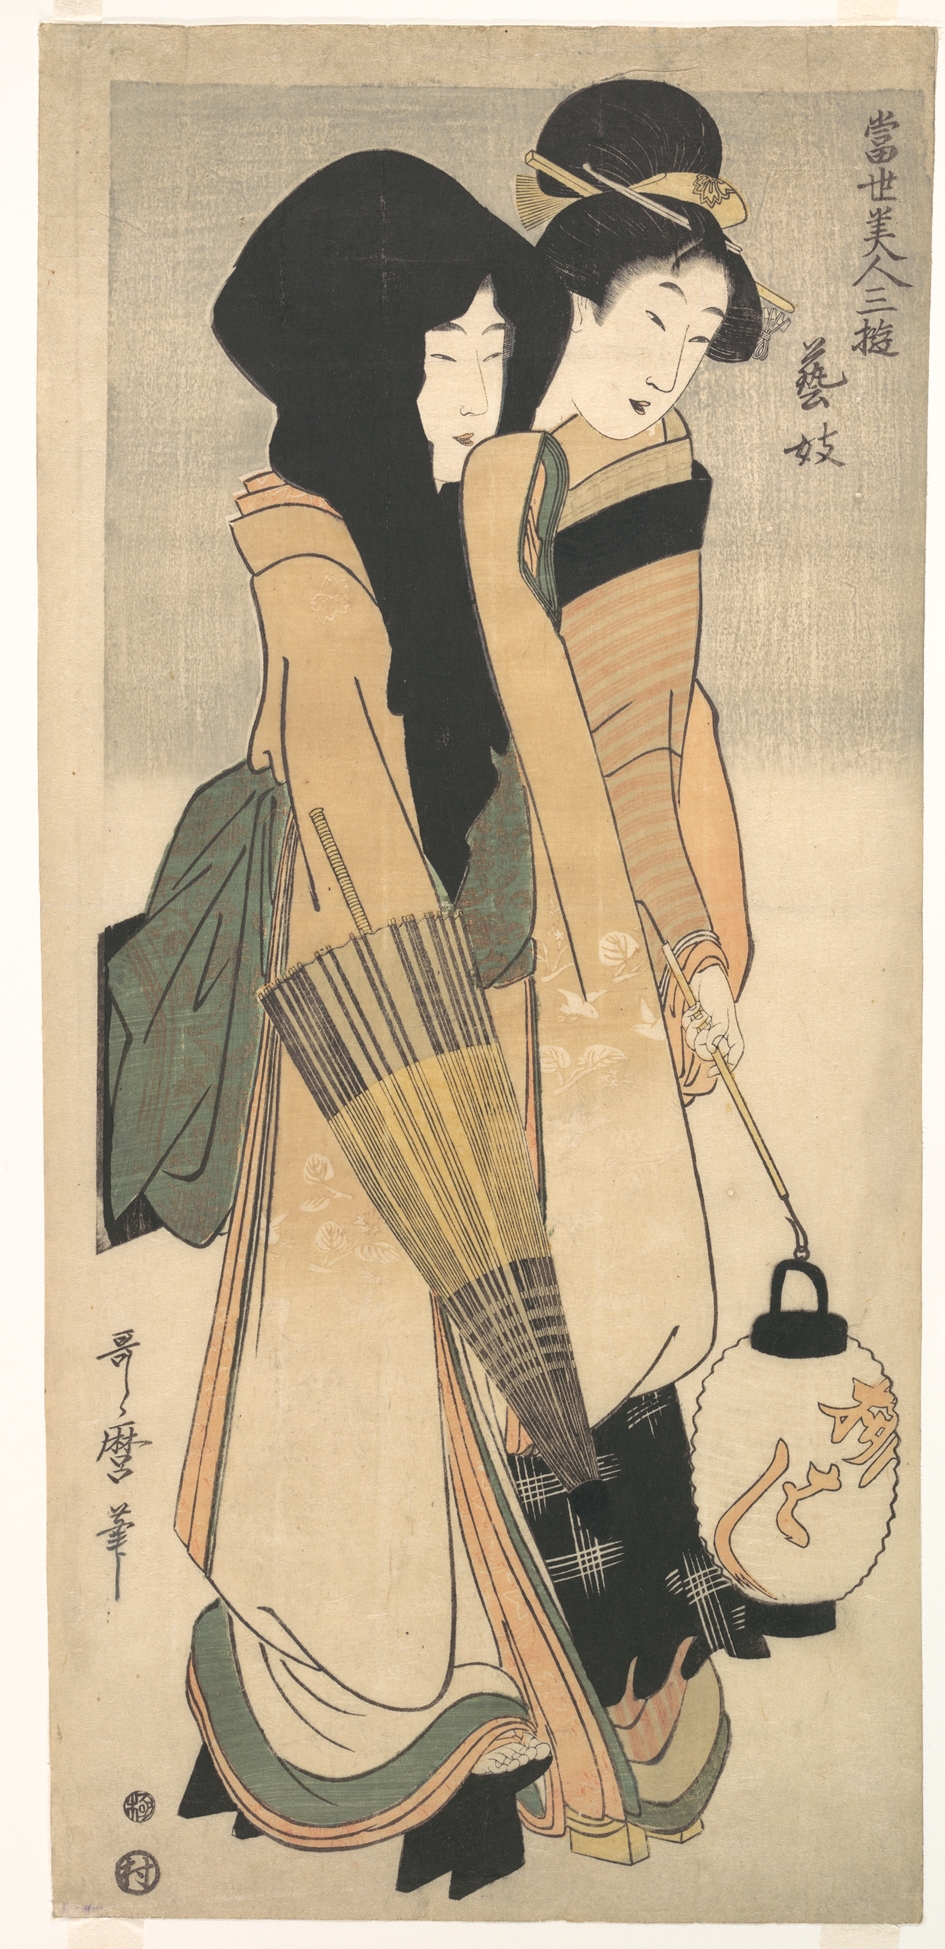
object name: print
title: “Geisha” from the series Three Amusements of Contemporary Beauties (Tōsei bijin san’yū: Geigi)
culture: japanese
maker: kitagawa utamaro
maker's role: artist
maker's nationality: japanese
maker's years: 1754-1806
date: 1800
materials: ink, paper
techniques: woodblock print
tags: women